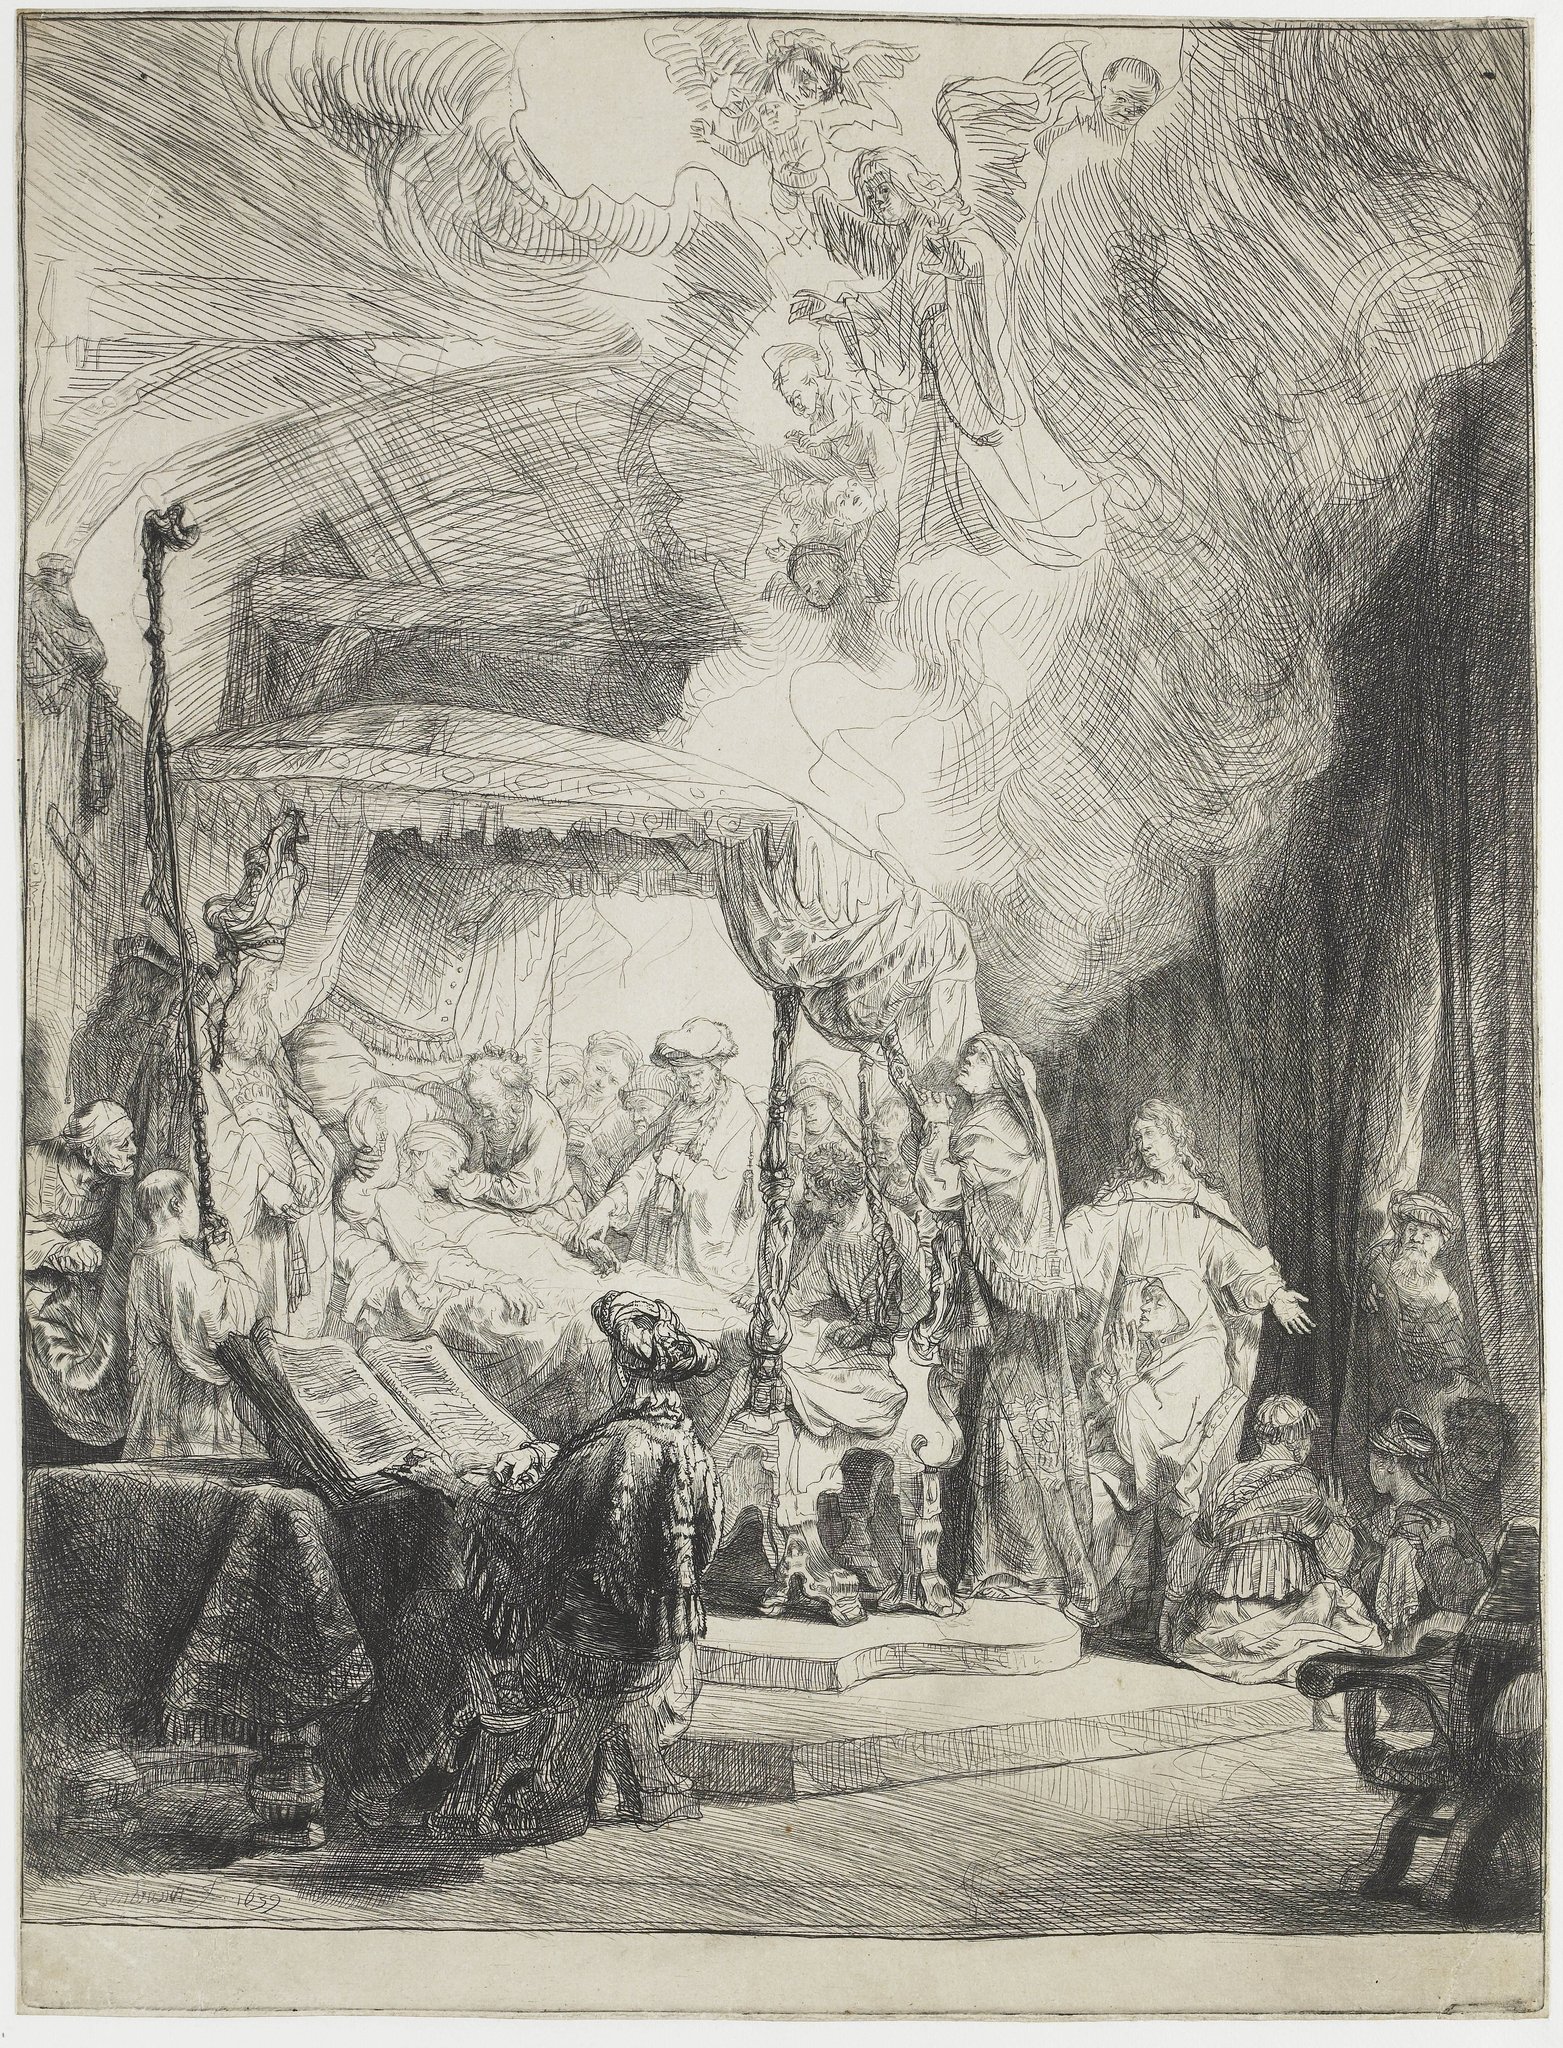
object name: print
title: The death of the Virgin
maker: rembrandt van rijn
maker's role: draughtsman, painter, print maker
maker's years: 1606-1669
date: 1639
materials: paper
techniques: drypoint, etching, intaglio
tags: the dormition: mary on her deathbed; the apostles are gathered around her (john the evangelist may be shown sleeping or dreaming)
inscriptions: collector's mark: Lugt 130, collector's mark: Lugt 2228, signature and date: ‘Rembrandt f 1639’, collector's mark: Lugt 2373